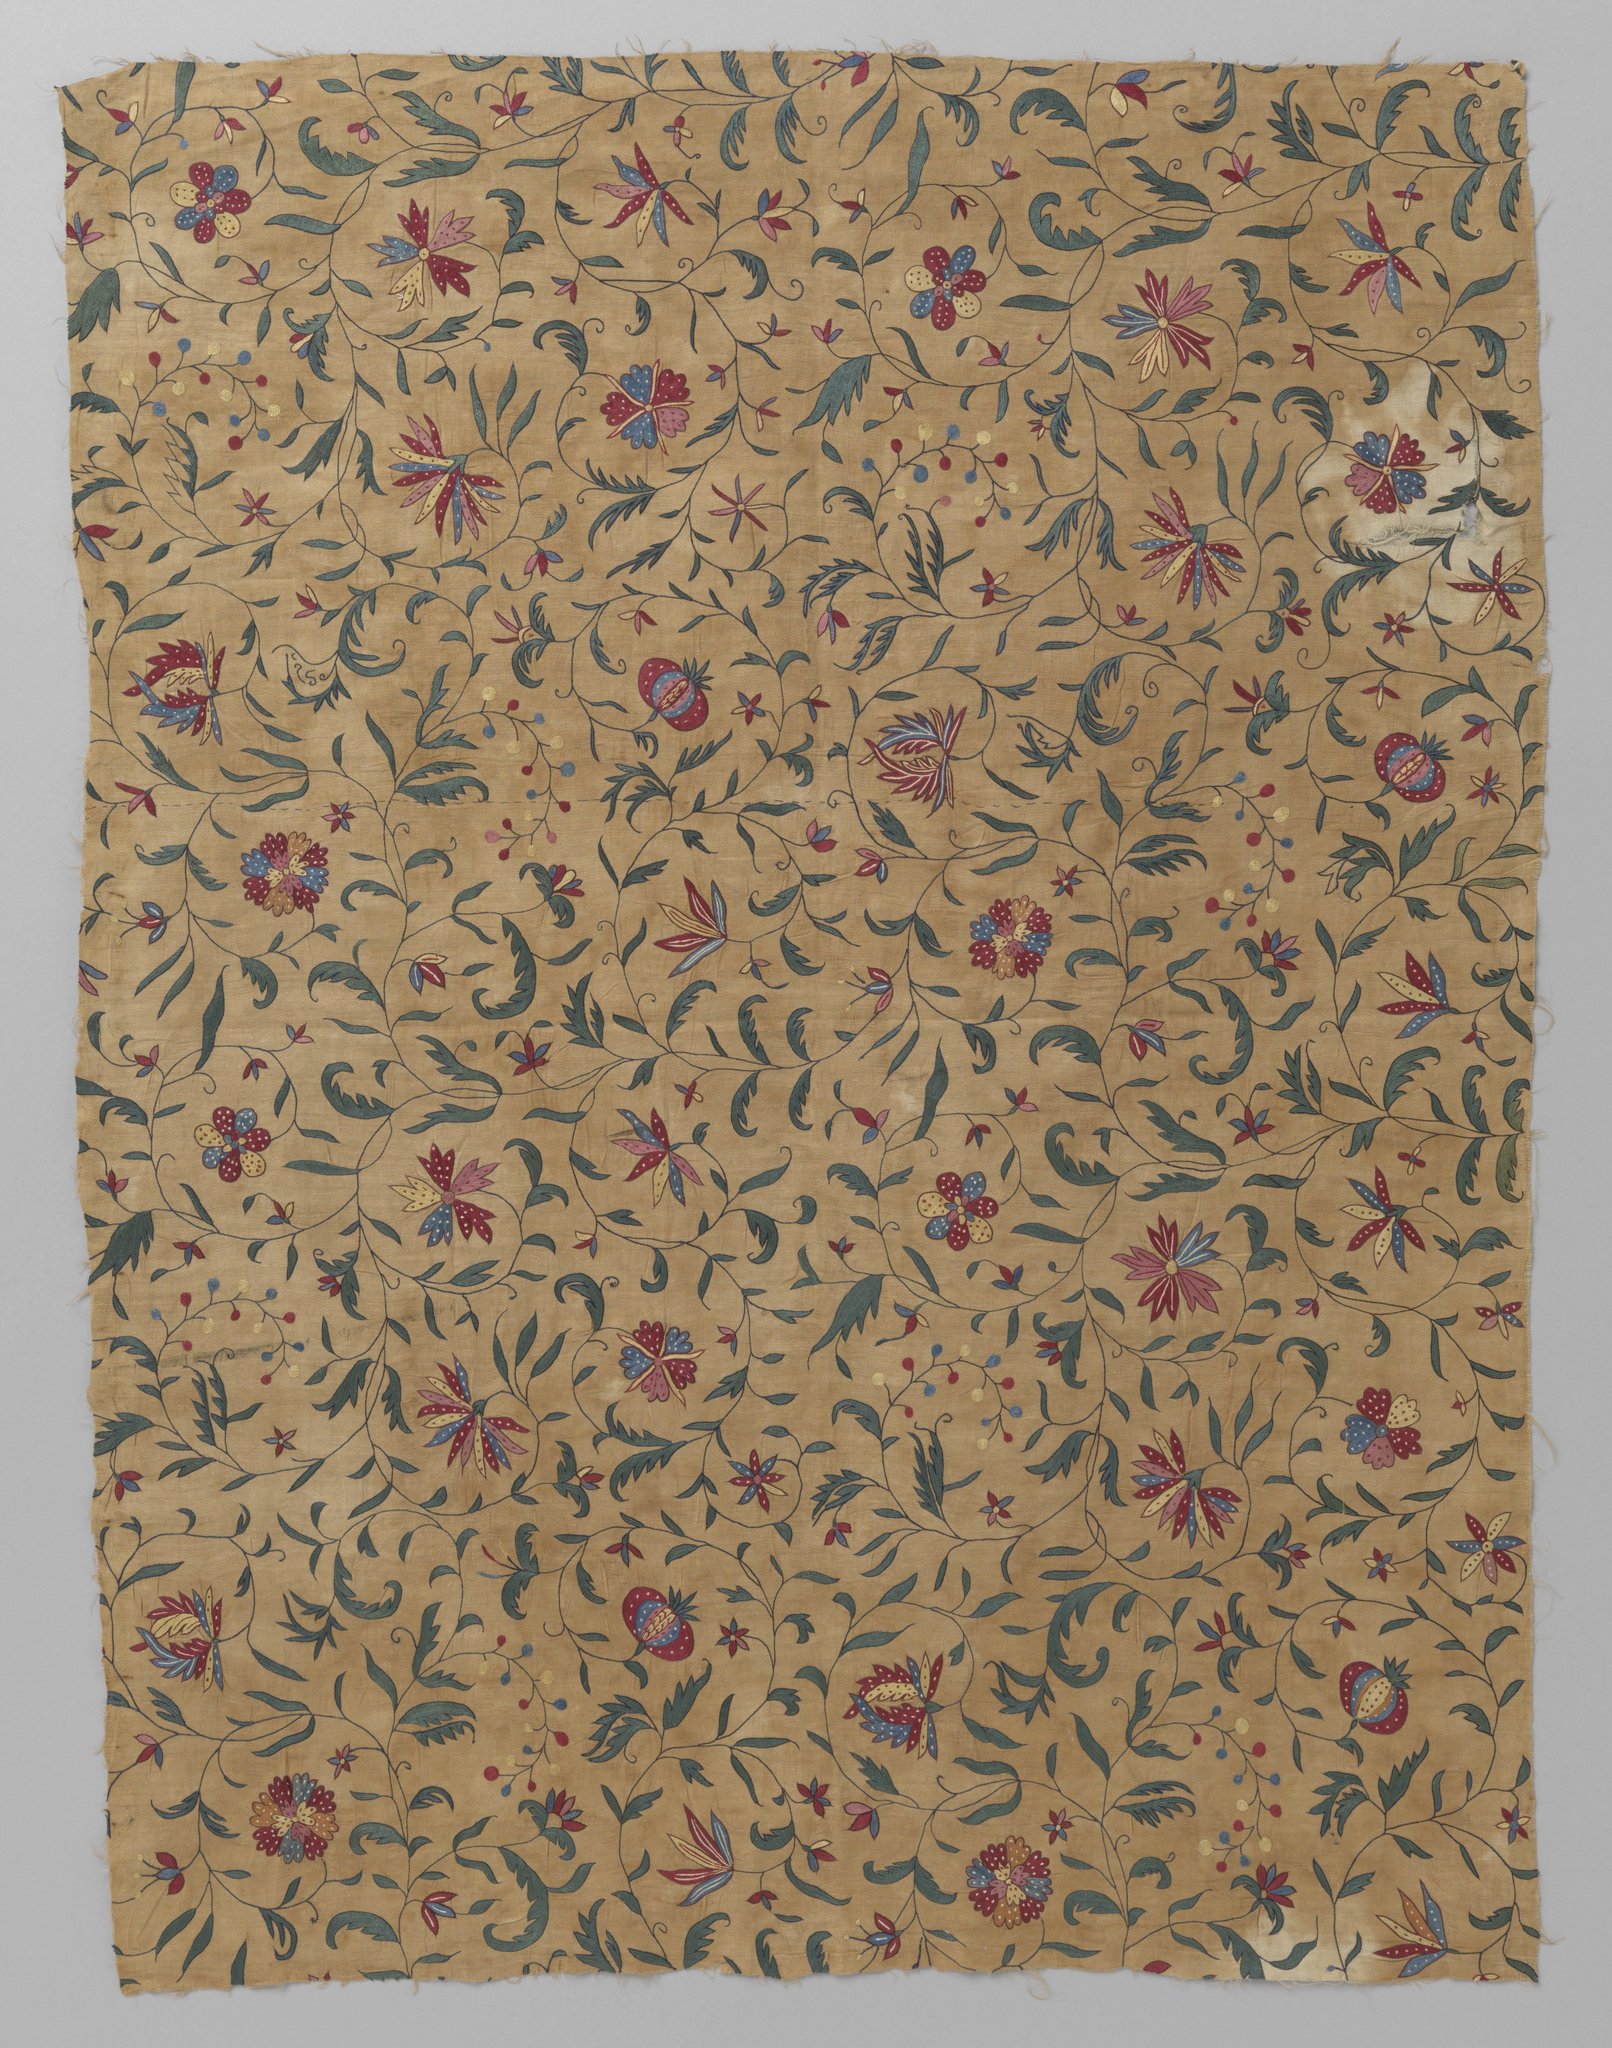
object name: fragment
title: Fragment katoen met veelkleurig borduurwerk in zijde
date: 1675-1725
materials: cotton, silk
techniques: embroidered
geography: iran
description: Fragment, vermoedelijk van hetzelfde sprei als BK-NM-3613, van tamboereerwerk op katoen. Het patroon heeft dunne spiraalranken, waaraan rozetbloemen, kelkbloemen, granaatappels, bessen en bladeren. Beddengoed, mogelijk een sprei.